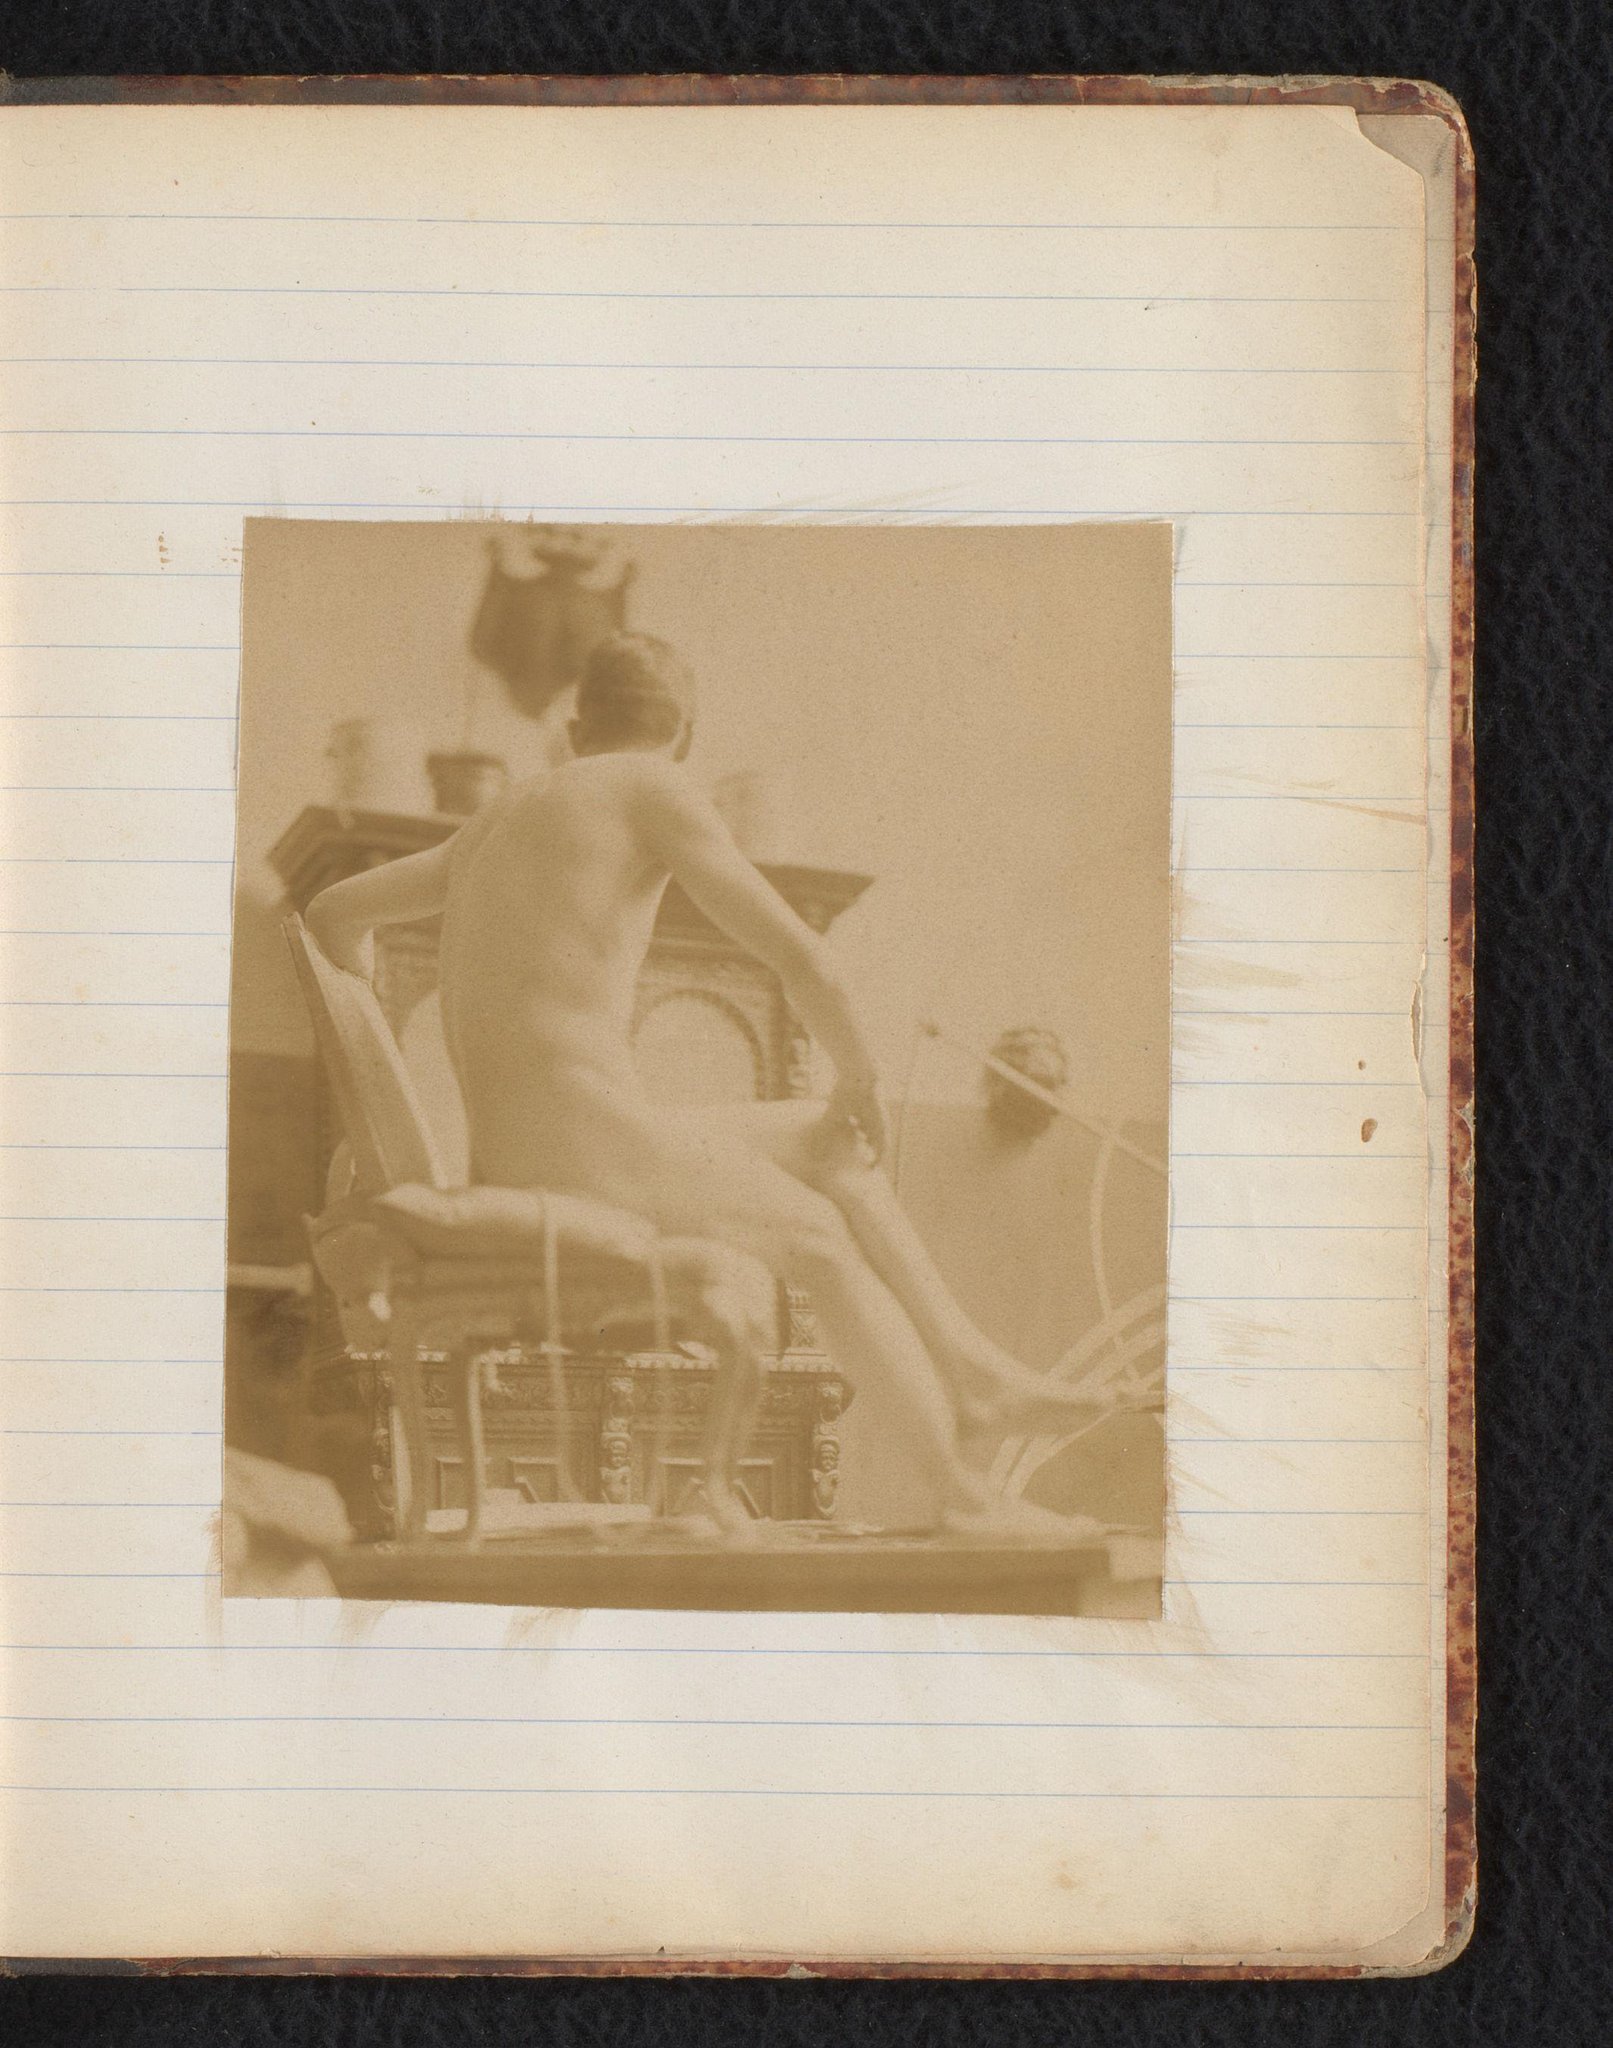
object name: album leaf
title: Studie van een mannelijk naaktmodel, zittend op een fauteuil en op de rug gezien, in het atelier van Jacques de Lalaing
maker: jacques lalaing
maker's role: painter, sculptor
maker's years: 1858-1917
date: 1883-1914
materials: photographic support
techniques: albumen print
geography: brussels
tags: adult man, artist (in general) working from nude model, the (nude) human figure; 'corpo humano' (ripa) (+ back view)